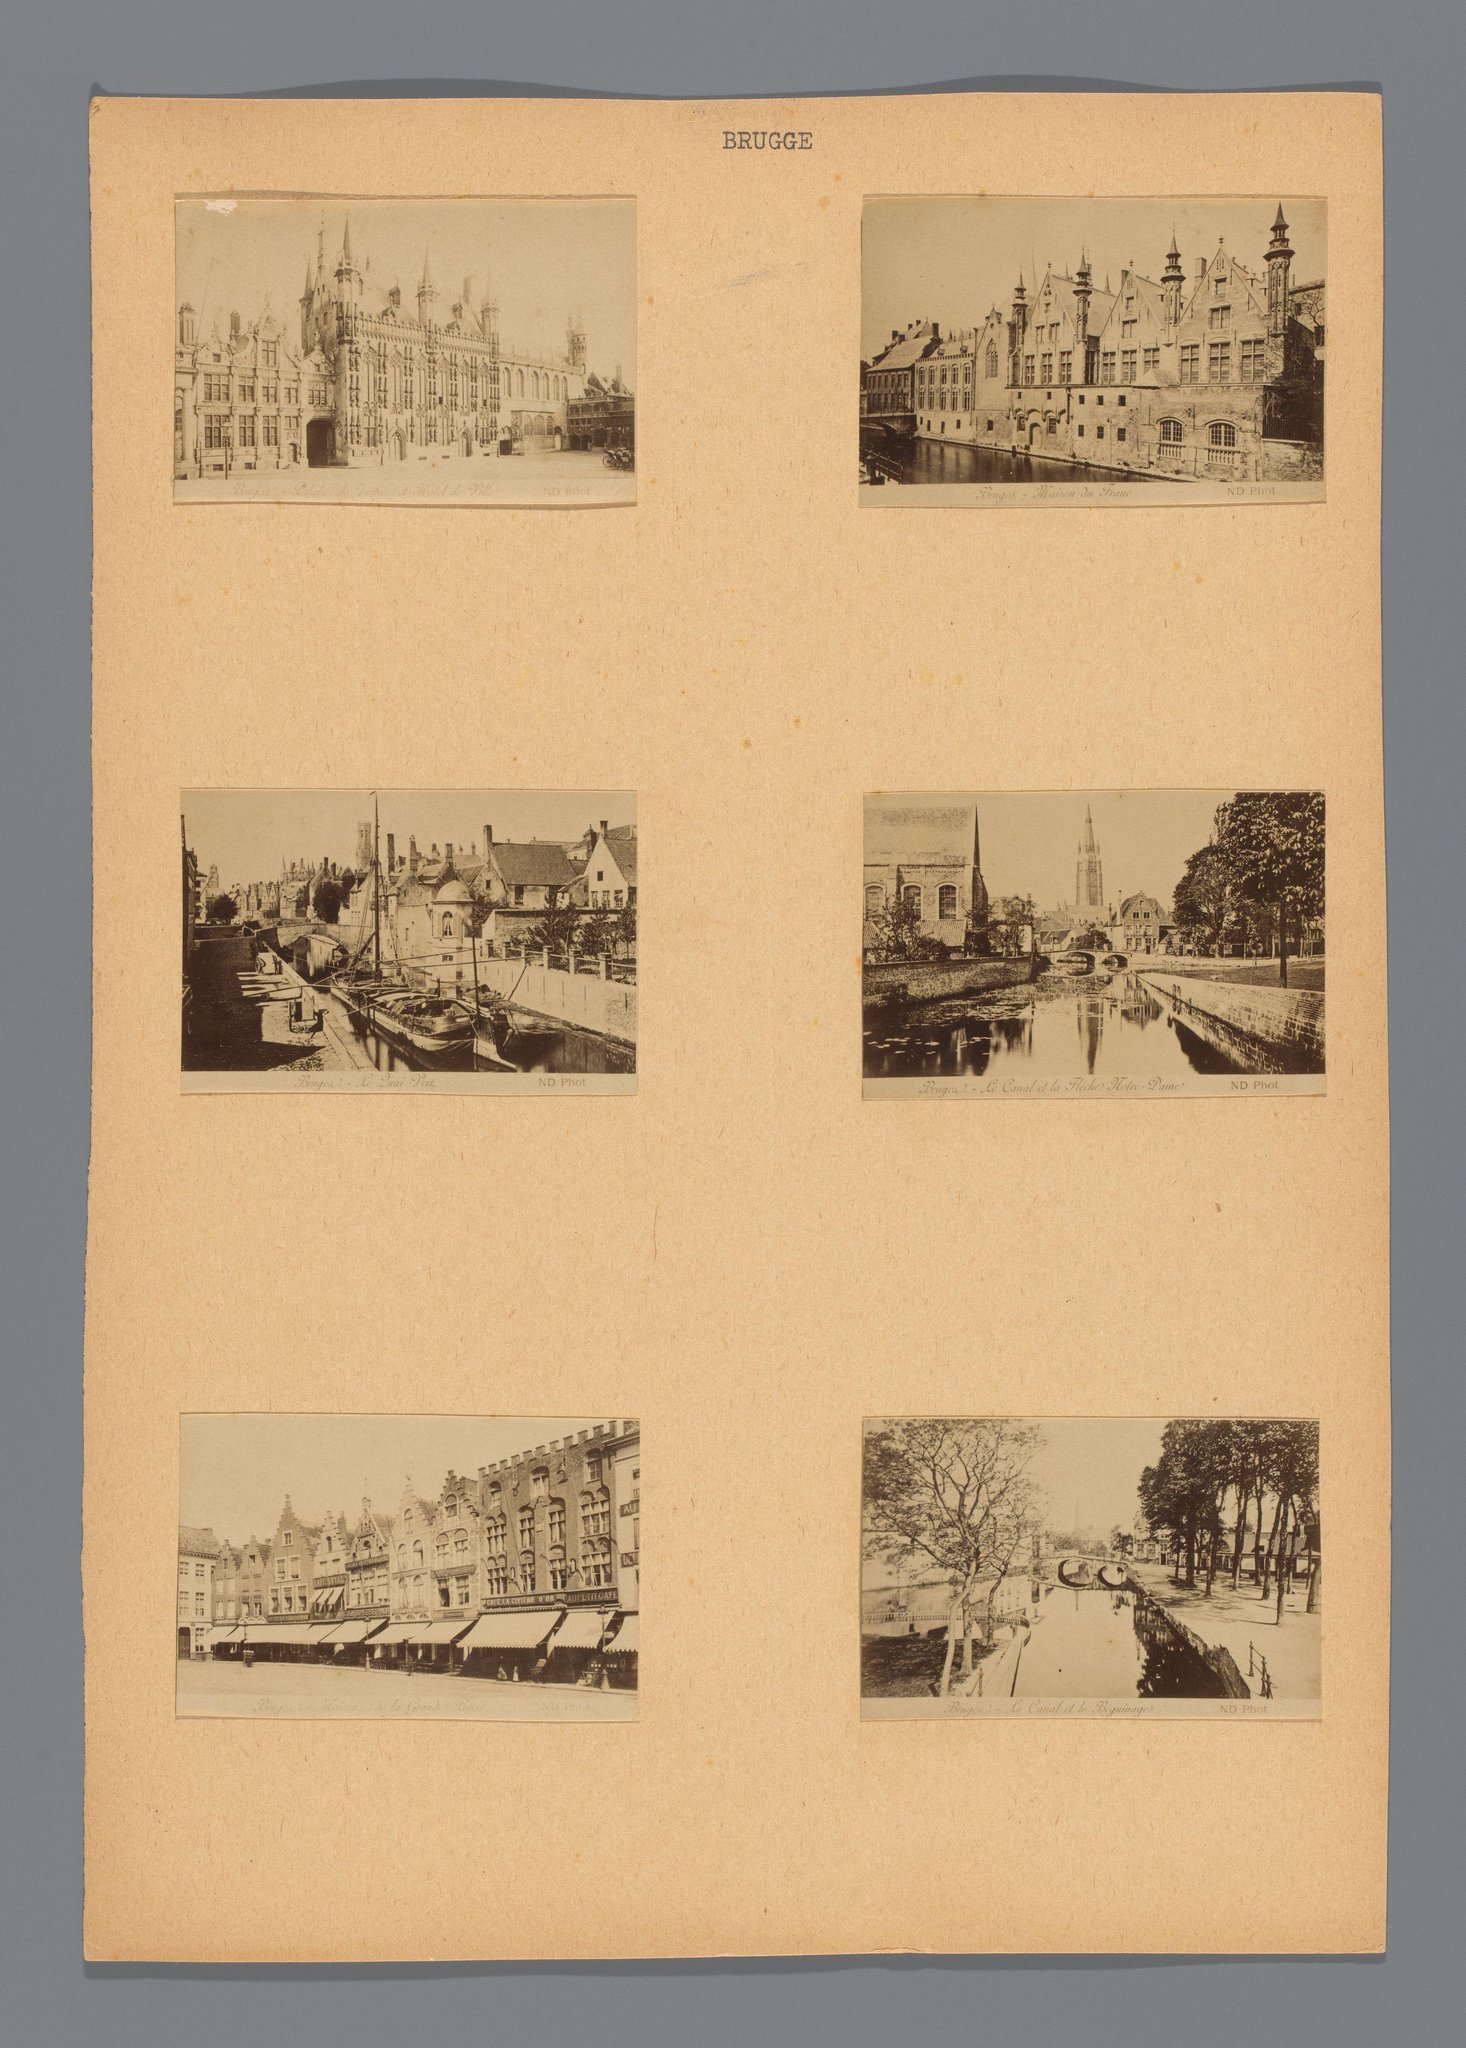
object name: photograph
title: Brugge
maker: Anonymous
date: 1850-1900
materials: photographic support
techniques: albumen print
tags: bruges